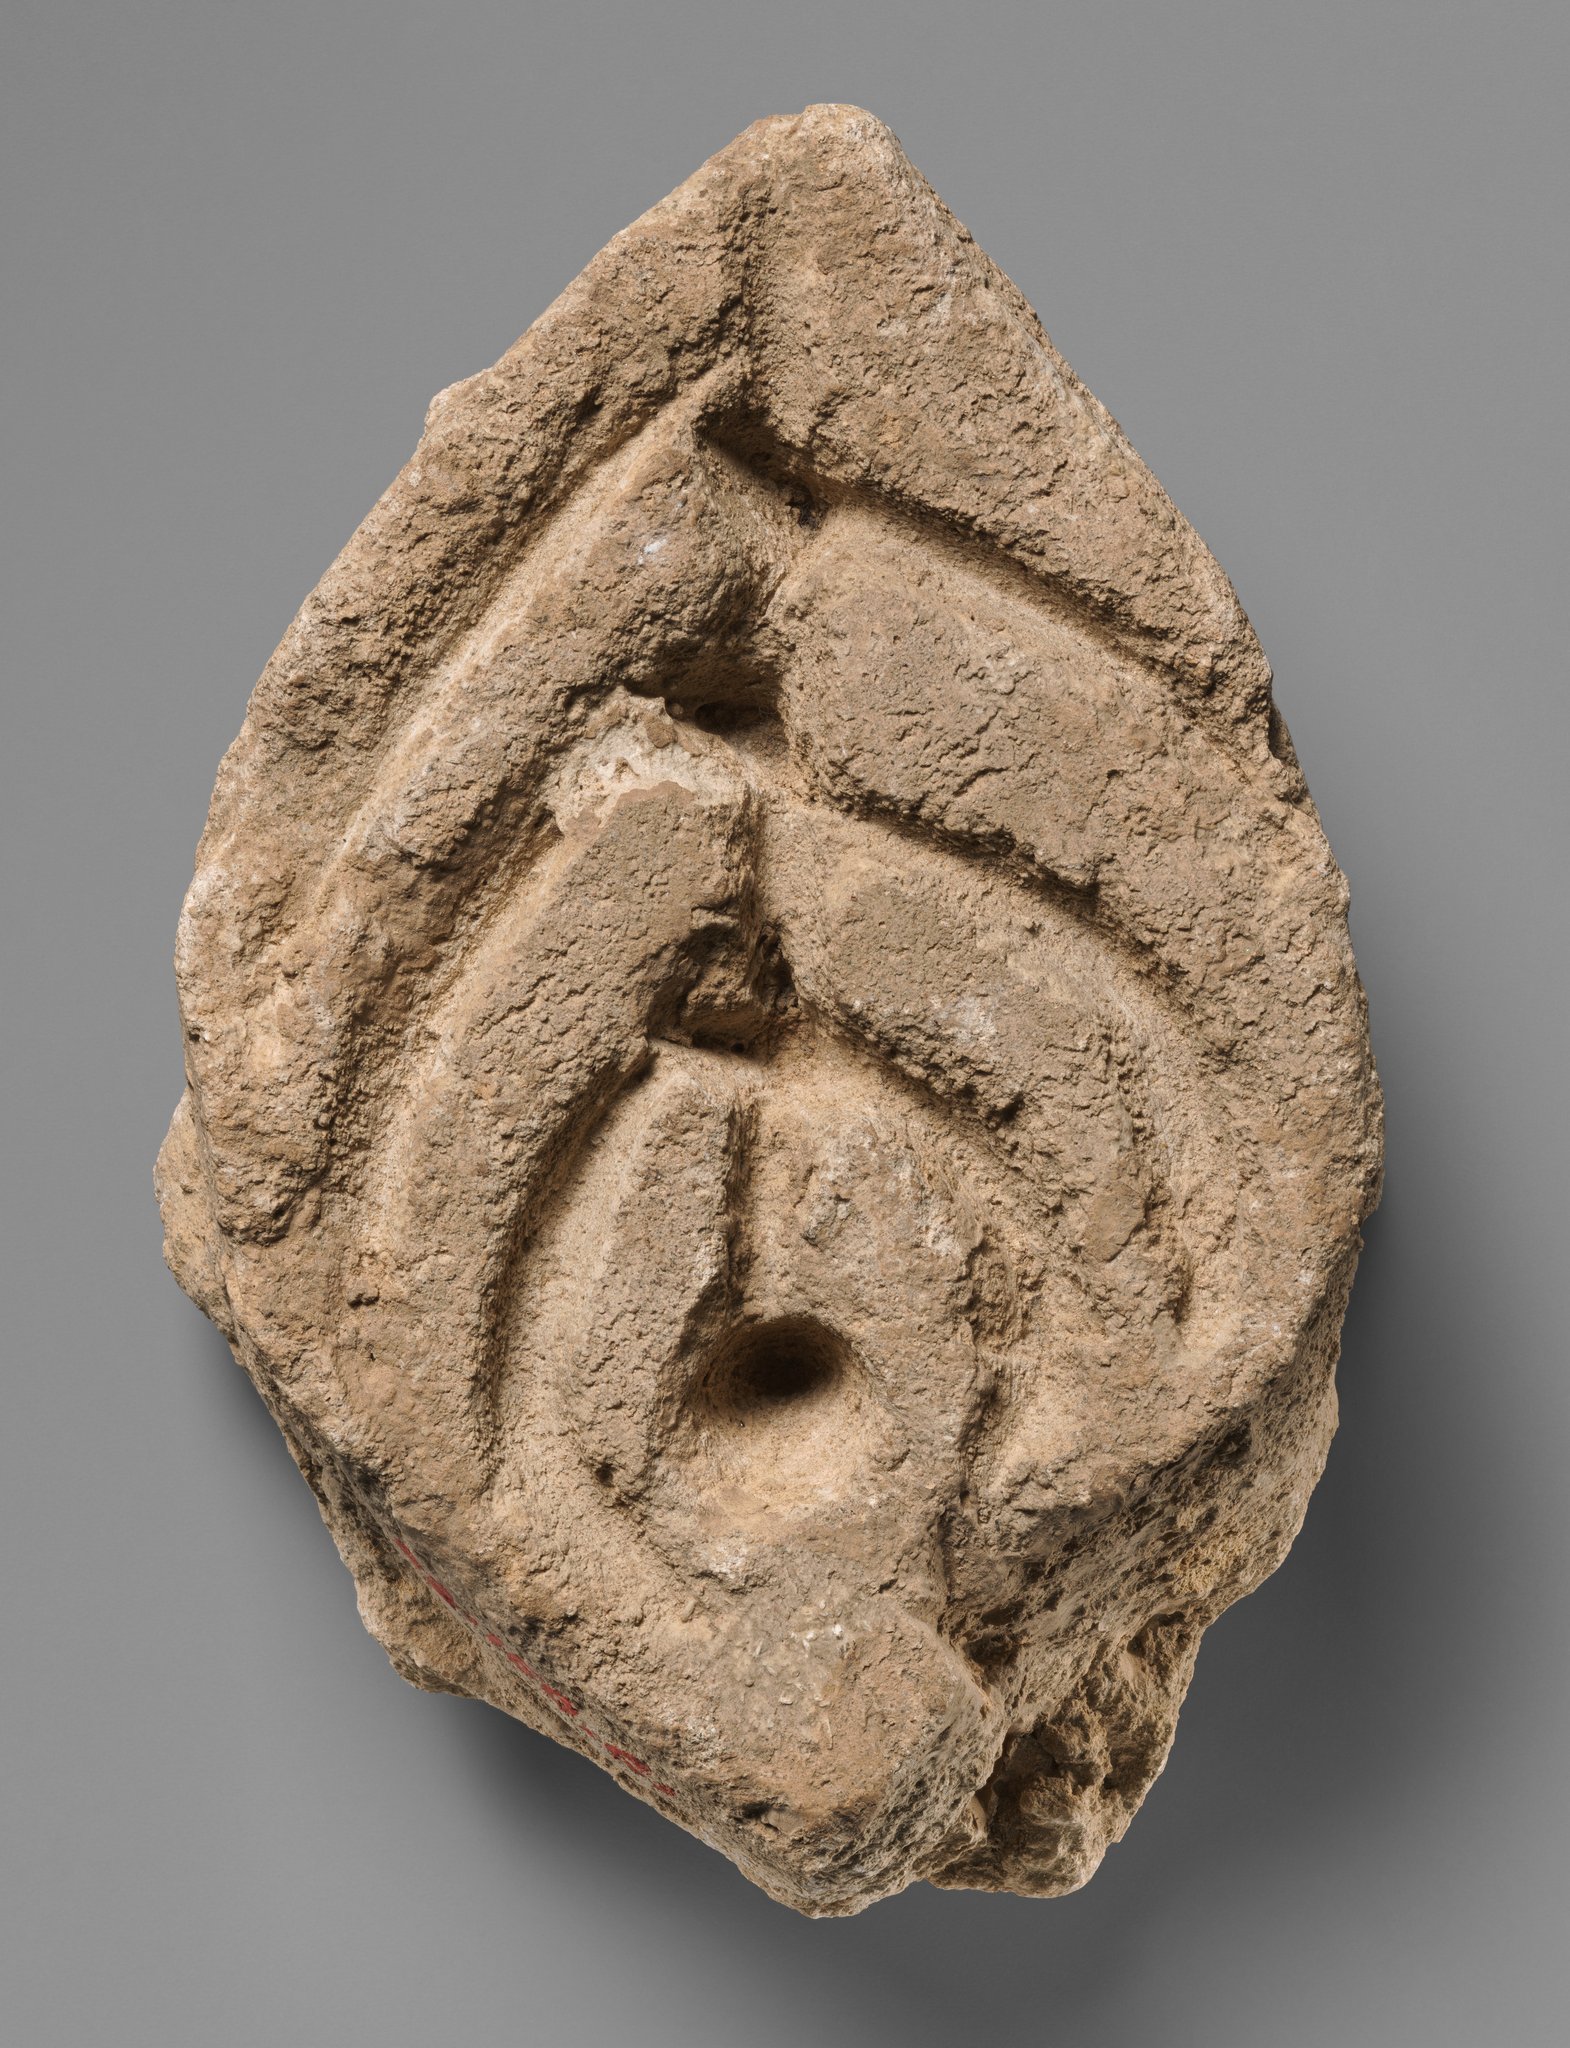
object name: relief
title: Relief fragment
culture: sasanian or islamic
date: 501-800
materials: plaster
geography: mesopotamia